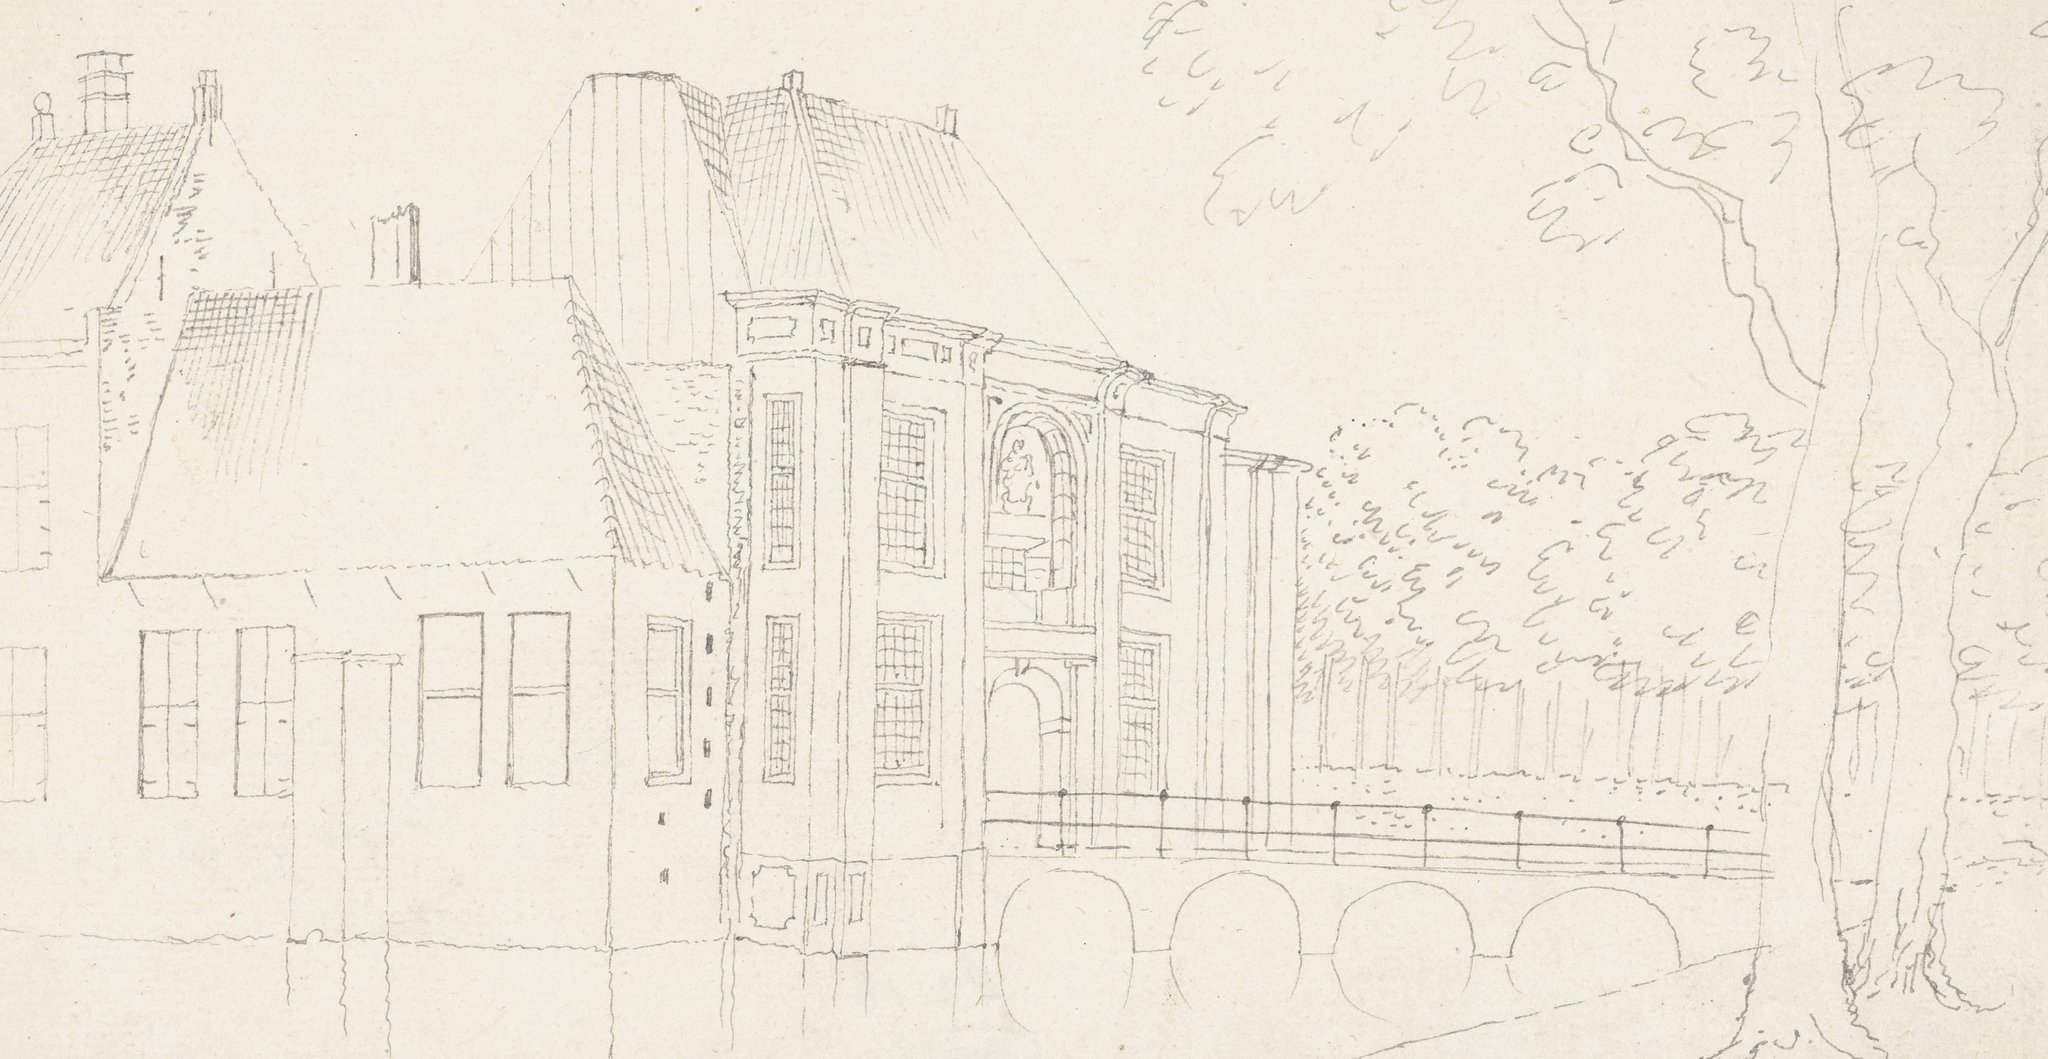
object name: drawing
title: Het huis ter Coulster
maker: cornelis pronk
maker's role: draughtsman, painter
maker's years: 1691-1759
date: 1701-1759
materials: ink, paper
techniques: pen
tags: castle